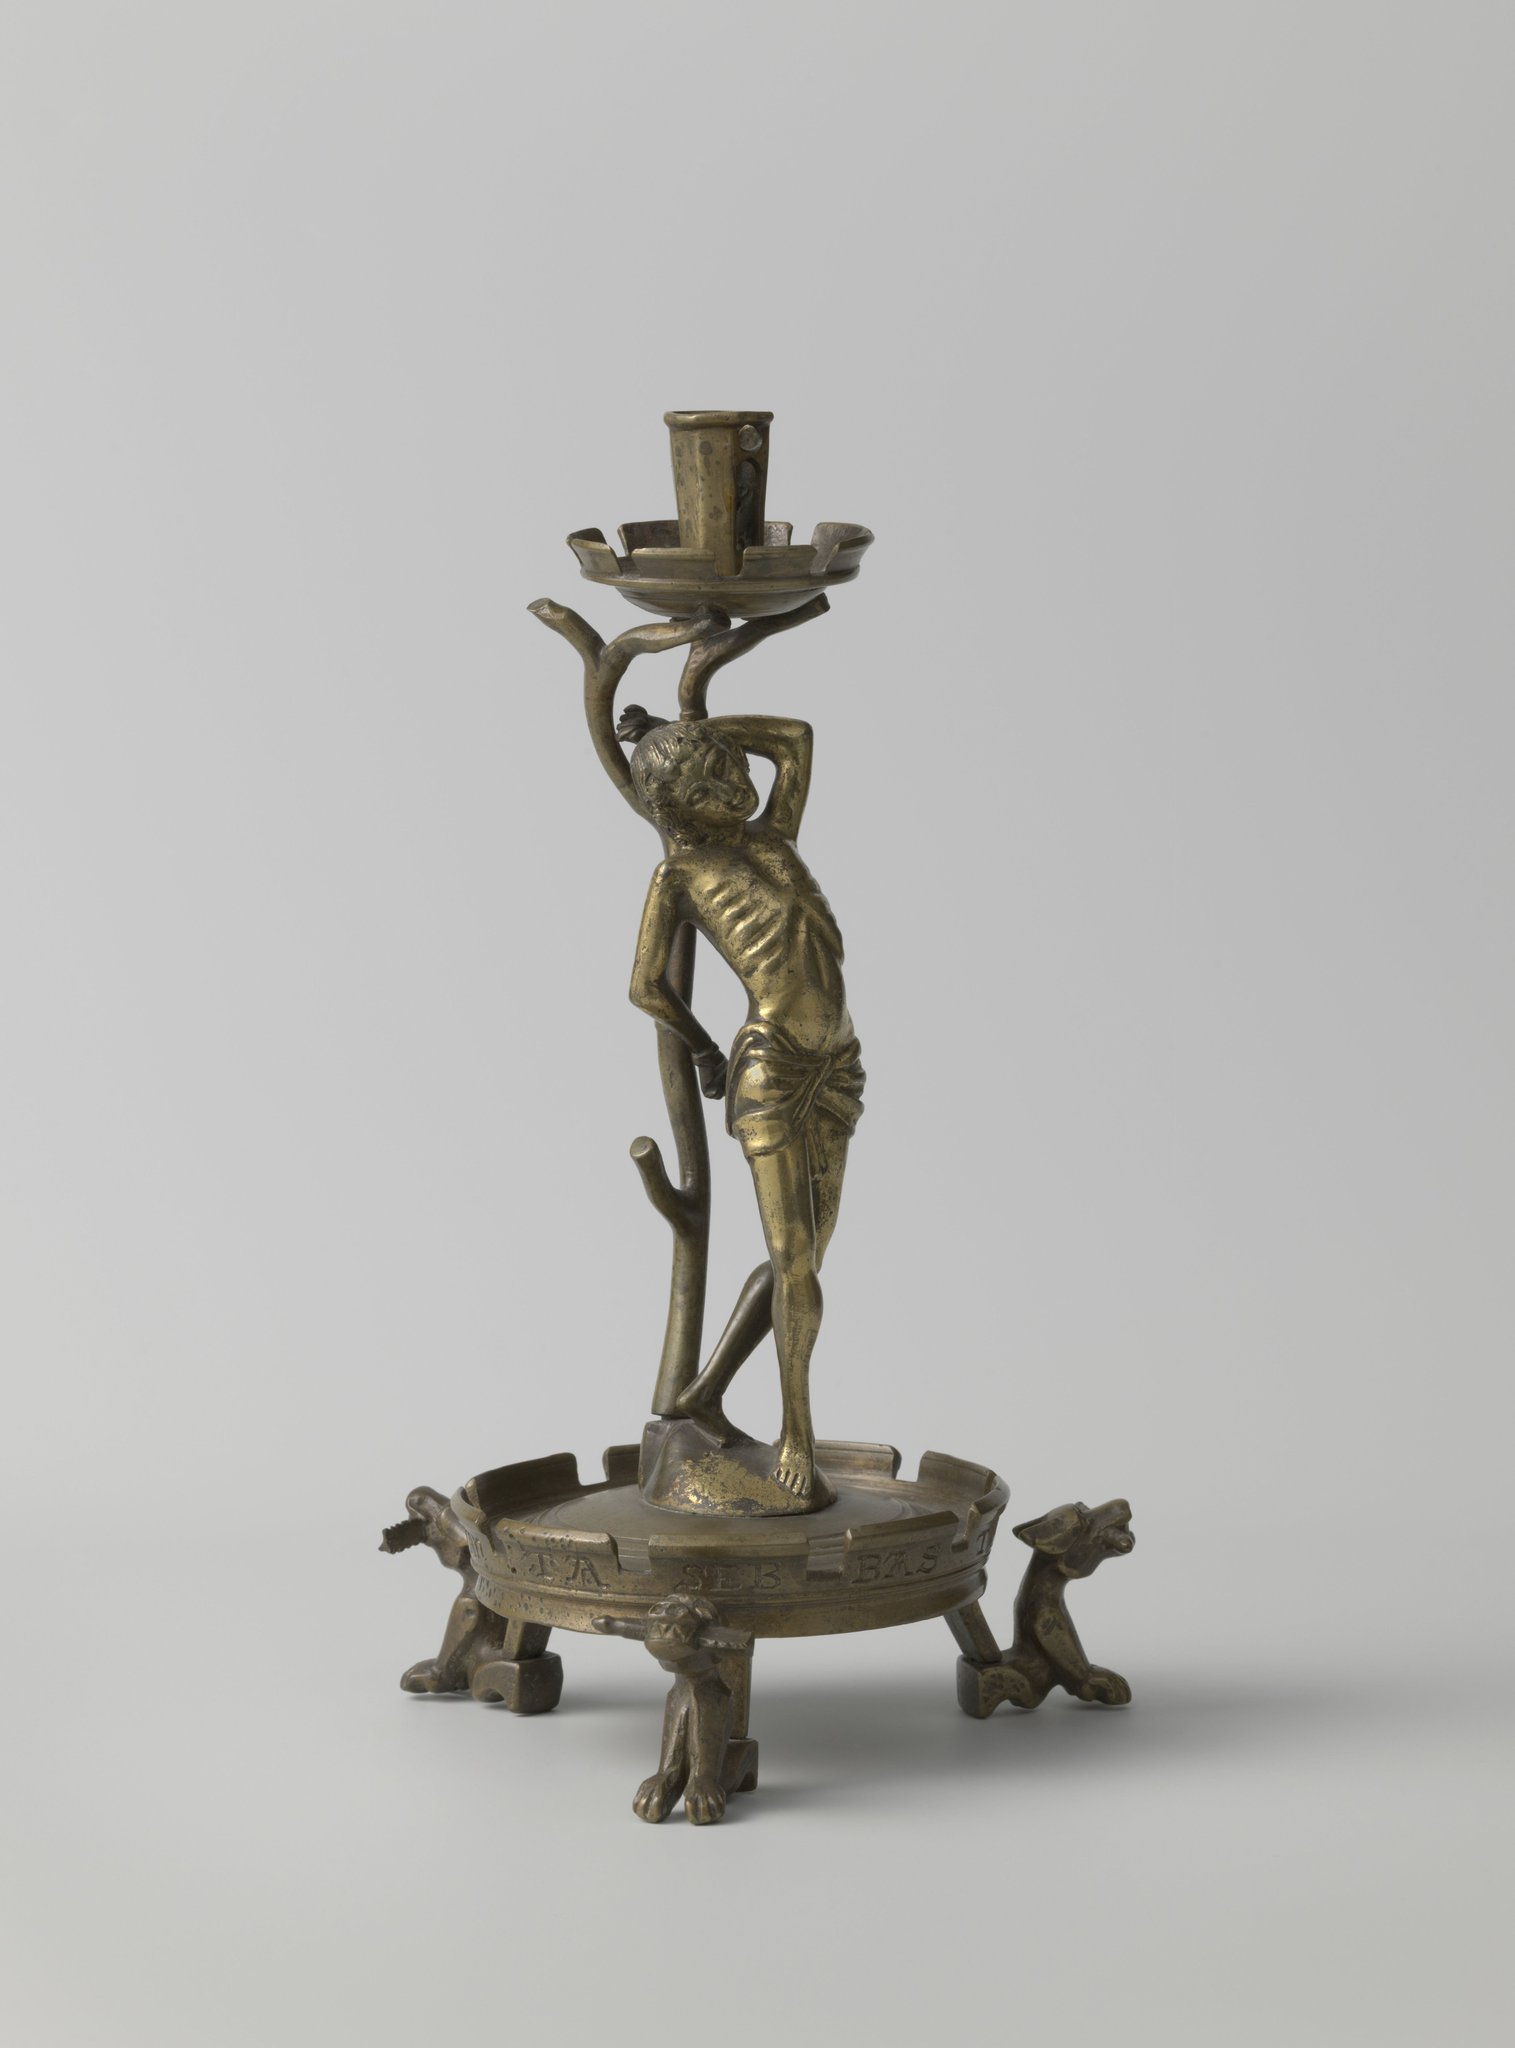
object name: candlestick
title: Kandelaar met de heilige Sebastiaan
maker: Anonymous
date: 1475-1500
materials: copper alloy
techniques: casting, metalworking, engraving, gilding, riveted, screwed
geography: southern netherlands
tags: the martyr sebastian; possible attributes: arrow(s), bow, tree-trunk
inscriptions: inscription: ‘+SAN TA SEB BAS TIA NUS ORA PRO NOBIS’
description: Candlestick with St Sebastian. Bronze or brass, parcel gilt. Southern Netherlands, c. 1475 - 1500.